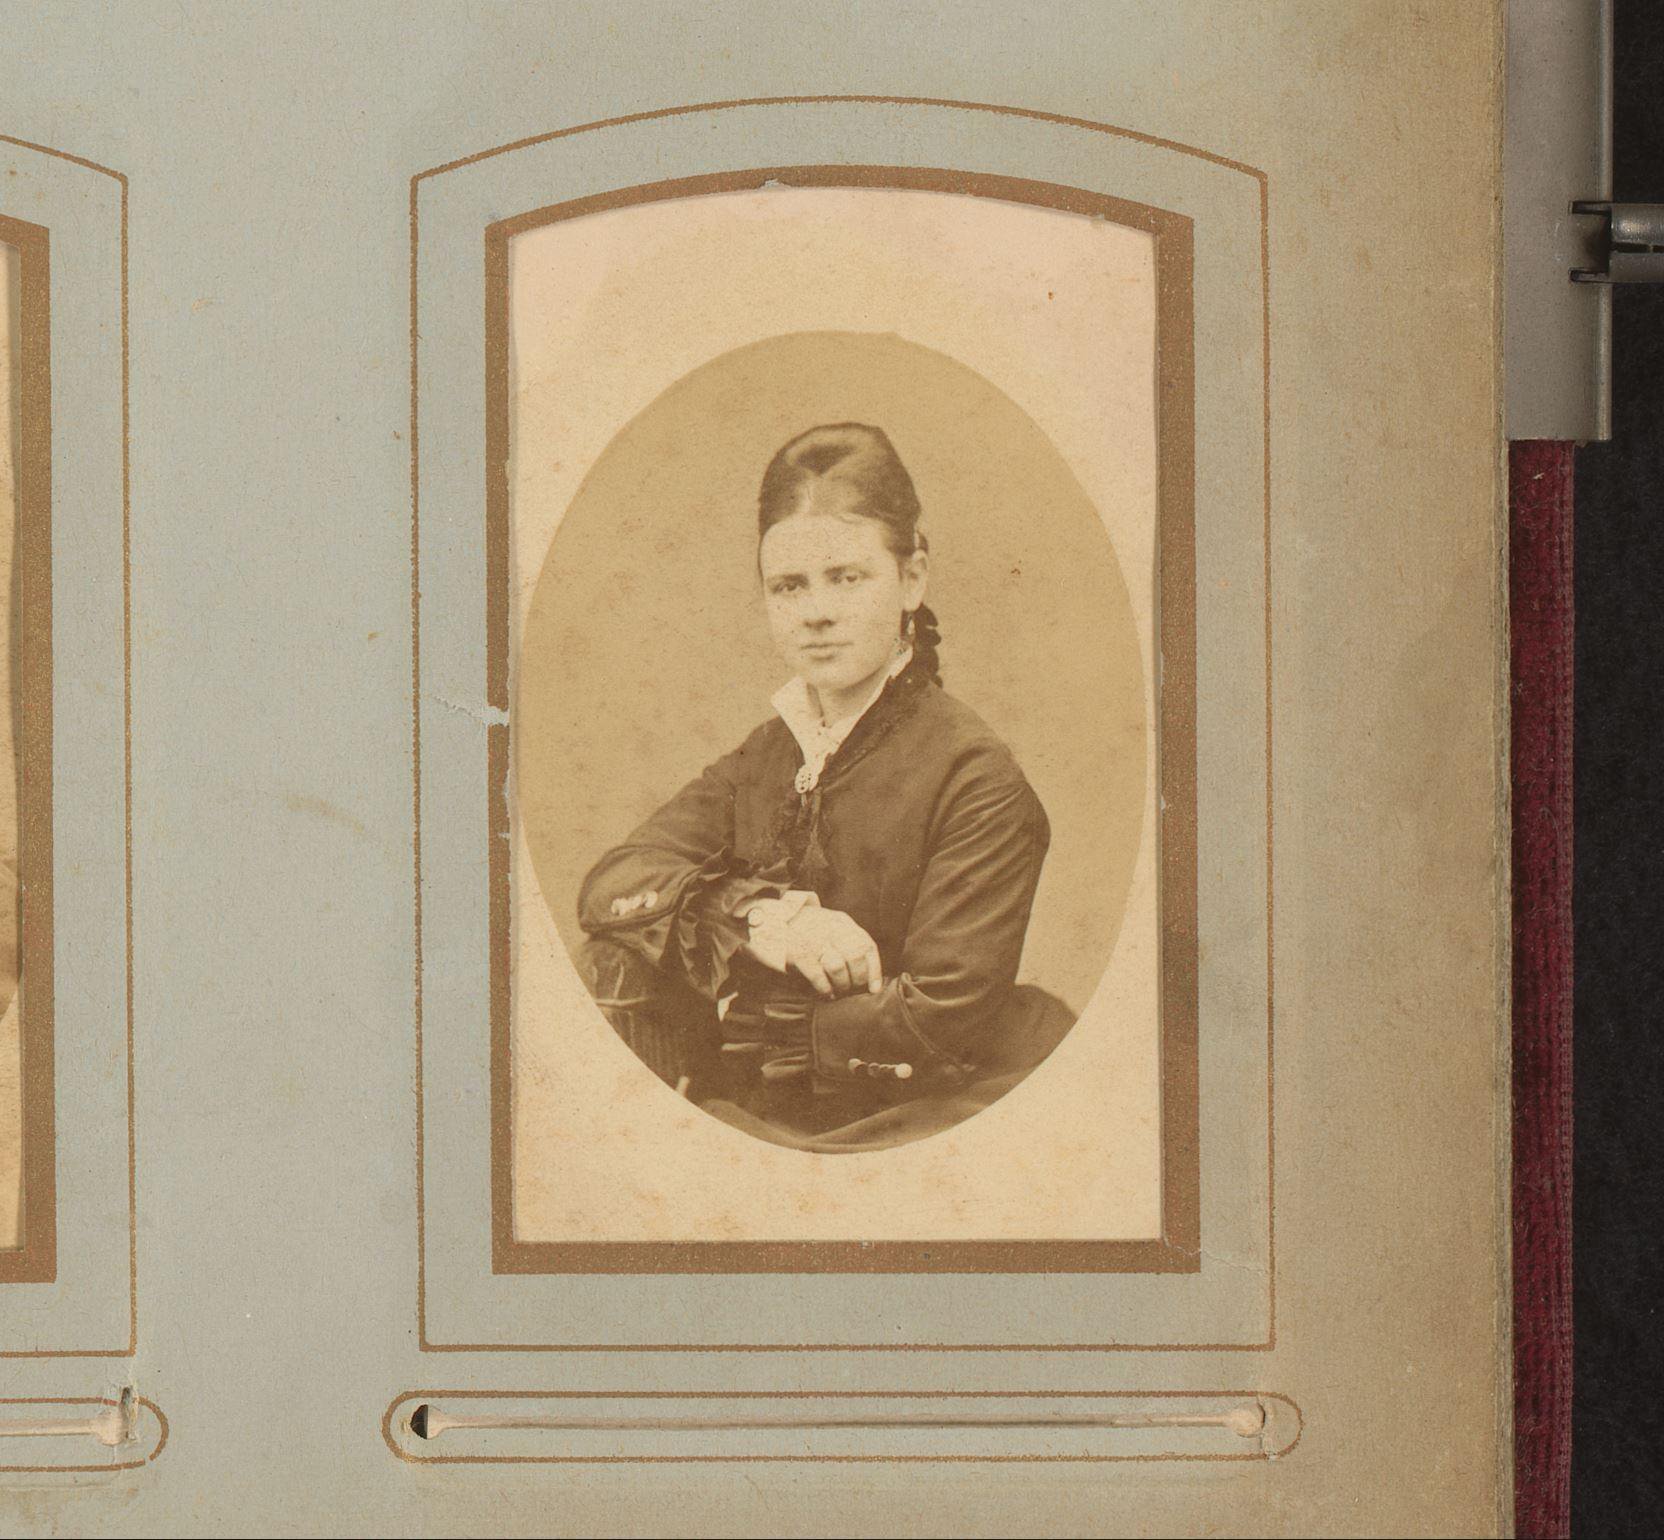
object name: photograph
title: Portret van een vrouw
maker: hermanus jodocus weesing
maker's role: fotograaf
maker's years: 1844-1910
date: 1868-1900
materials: cardboard, photographic support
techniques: albumen print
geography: amsterdam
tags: historical persons - bb - woman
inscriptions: inscription: ‘H.J. Weesing/ Photograaf/ Binnen Brouwerstraat/ 5/ Amsterdam’